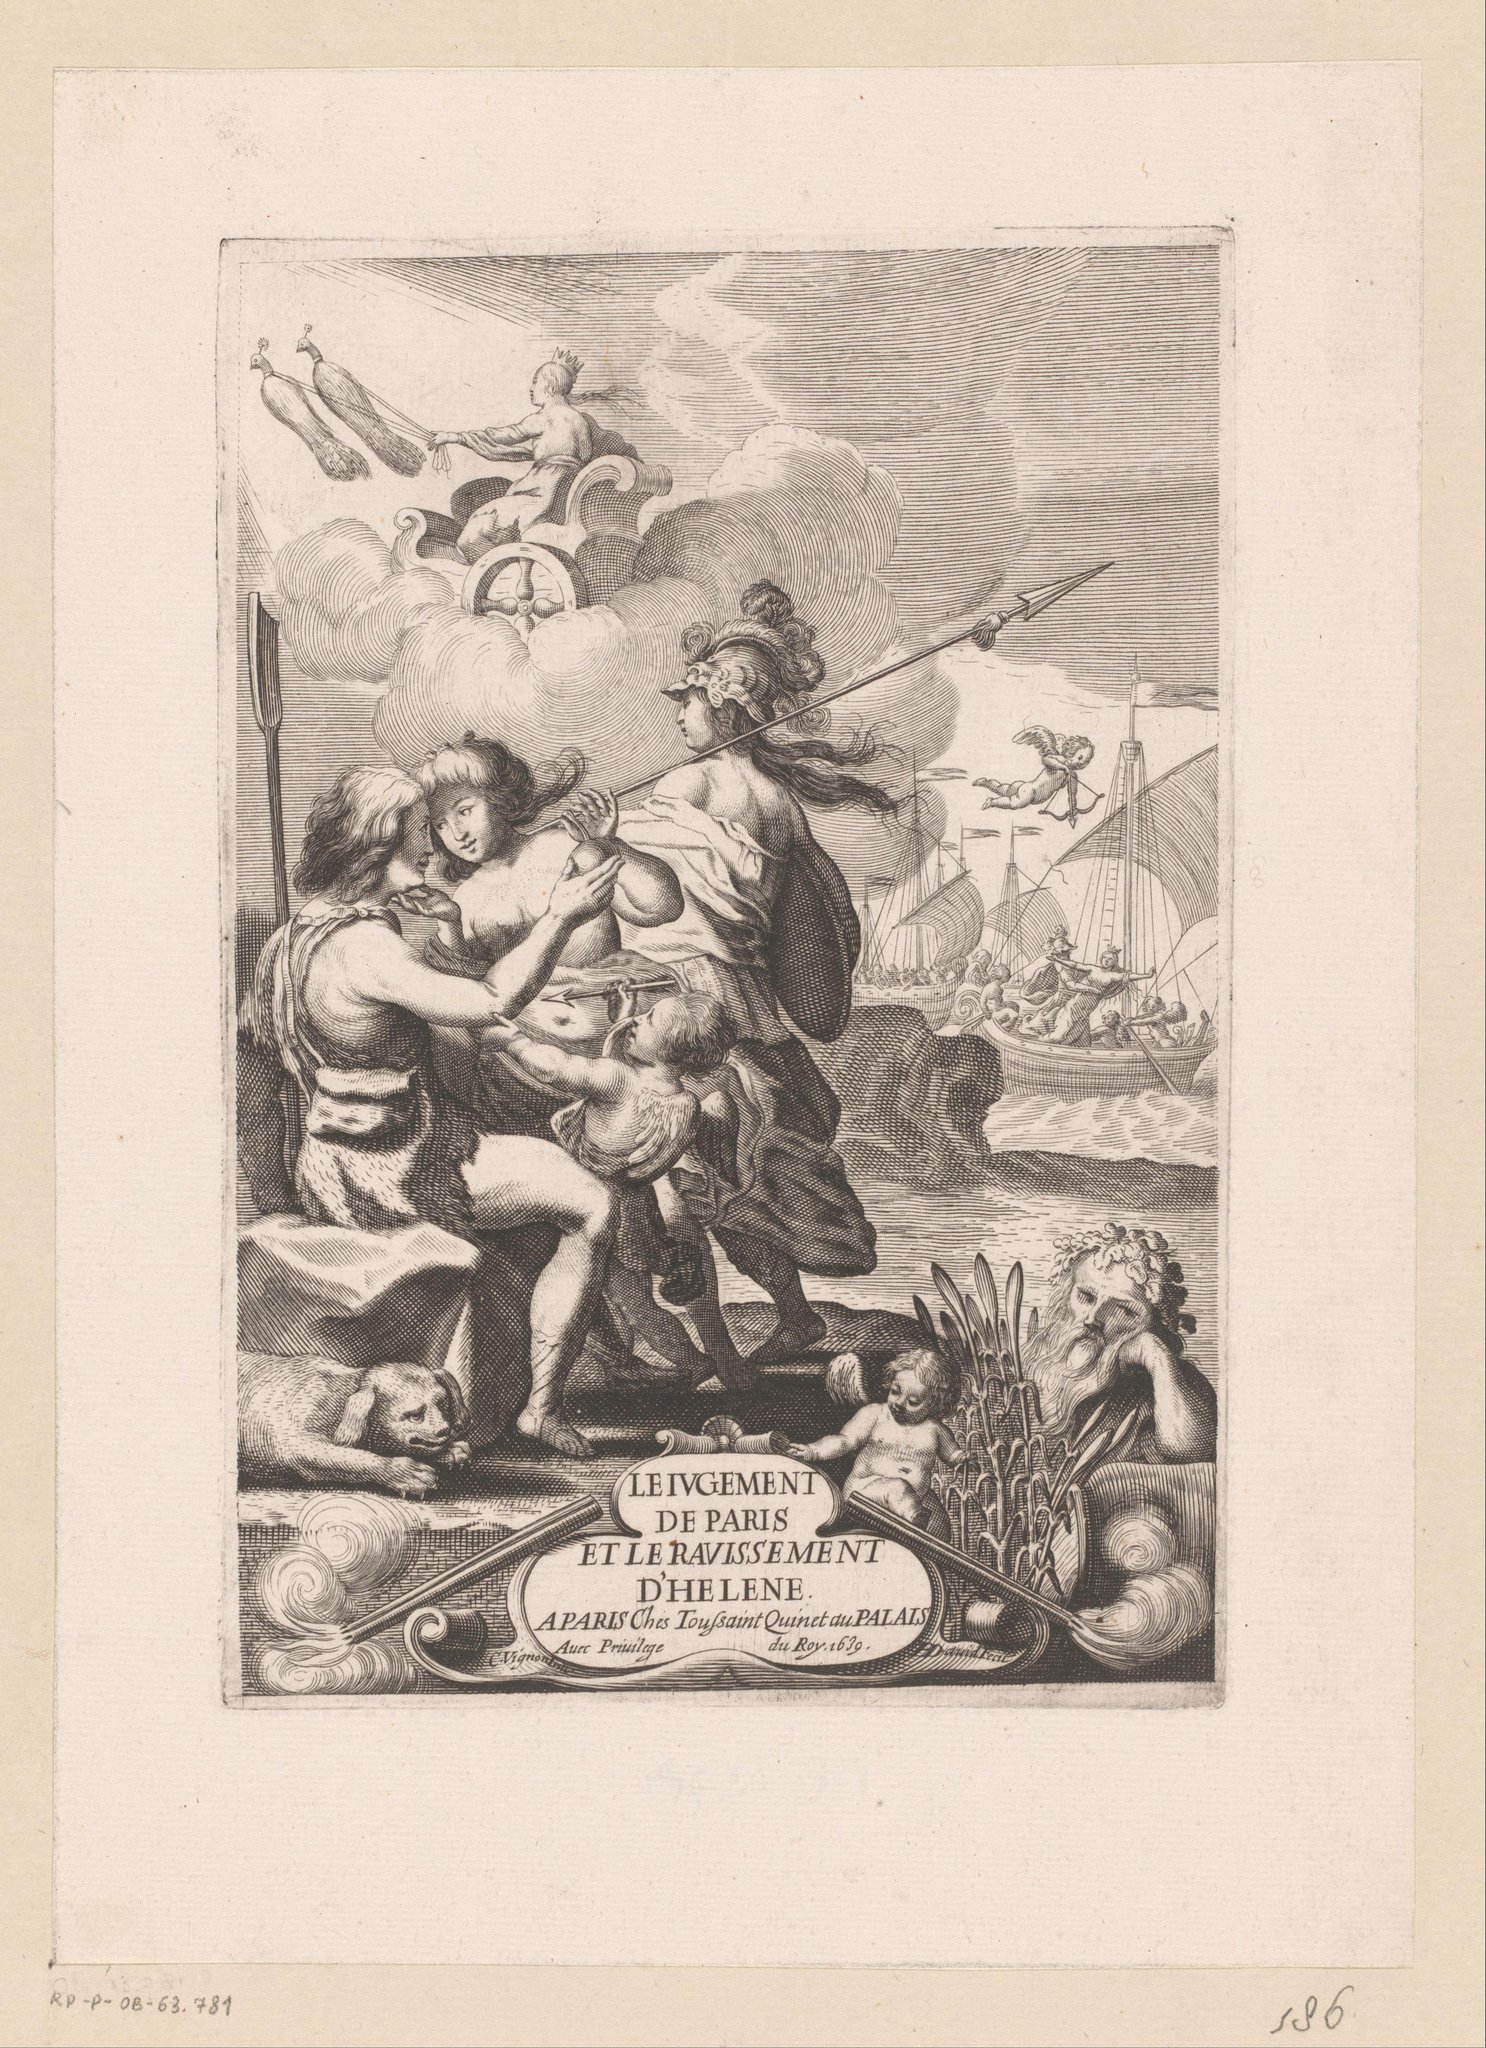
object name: print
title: Oordeel van Paris en de roof van Helena van Troje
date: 1639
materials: paper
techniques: engraving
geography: france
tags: the judgement of paris (without mercury), (story of) minerva (pallas, athena), the abduction of helen and some of her companions: paris carries them off by sea, and takes a part of the palace-treasure with him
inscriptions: collector's mark: Lugt 240